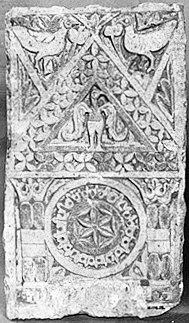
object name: stele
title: Funerary Stele with Cross Medallion below Eagle at Center in Architectural Frame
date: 501-700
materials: limestone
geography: egypt